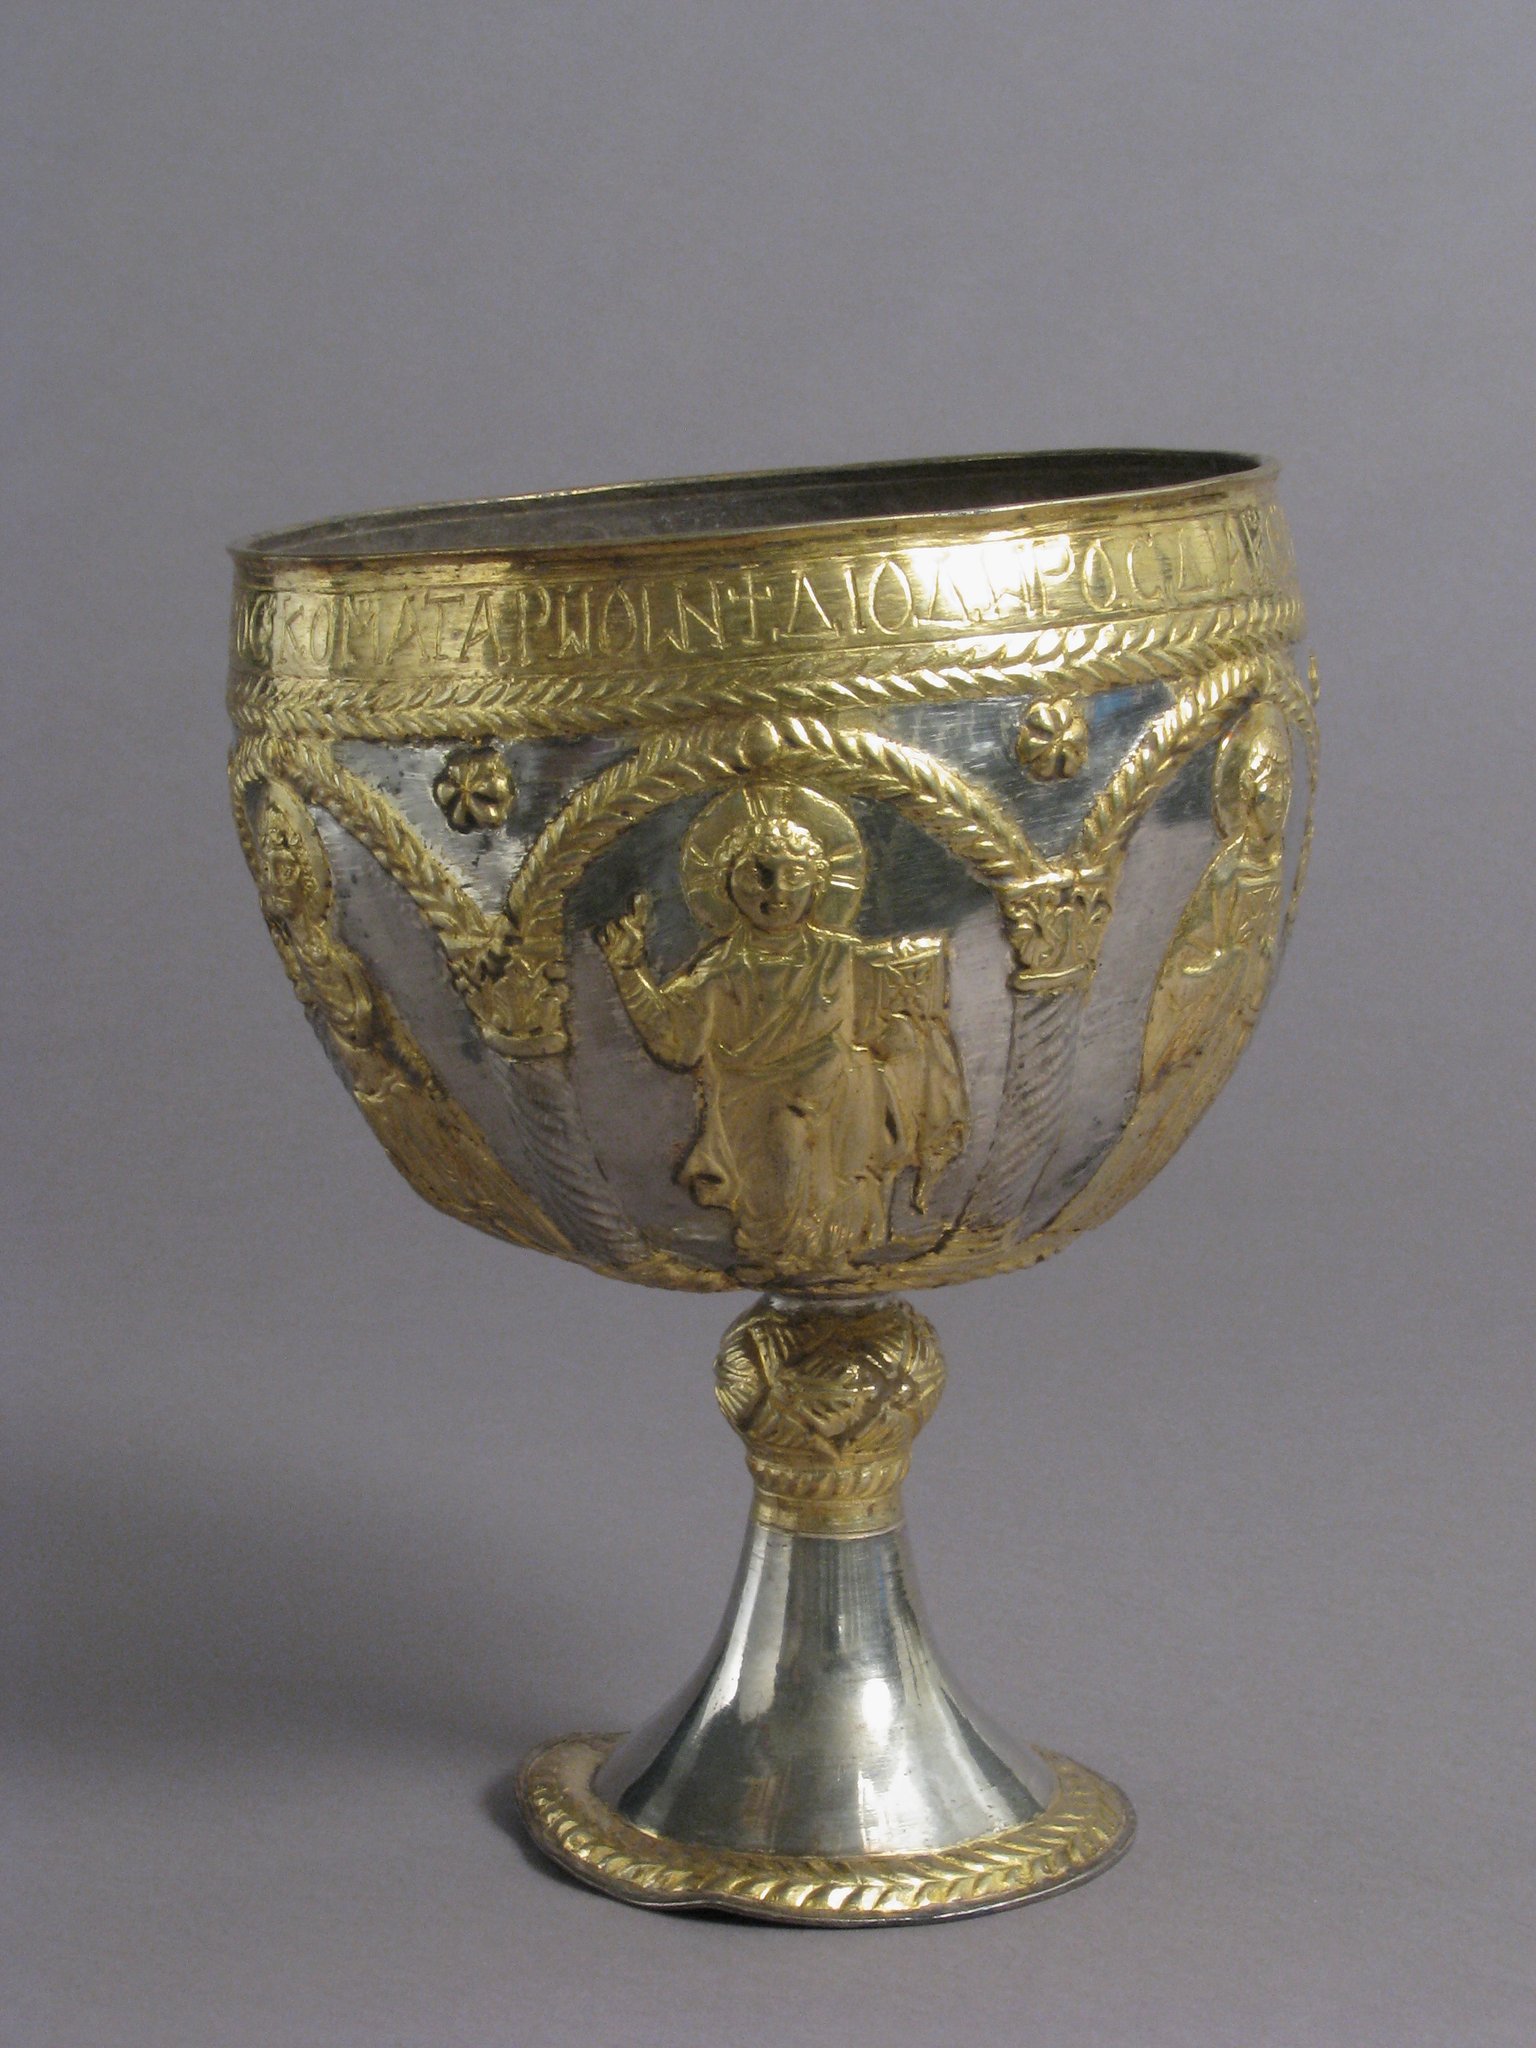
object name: chalice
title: The Attarouthi Treasure - Chalice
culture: byzantine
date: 500-650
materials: gilt silver, silver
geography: syria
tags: virgin mary,jesus,saints